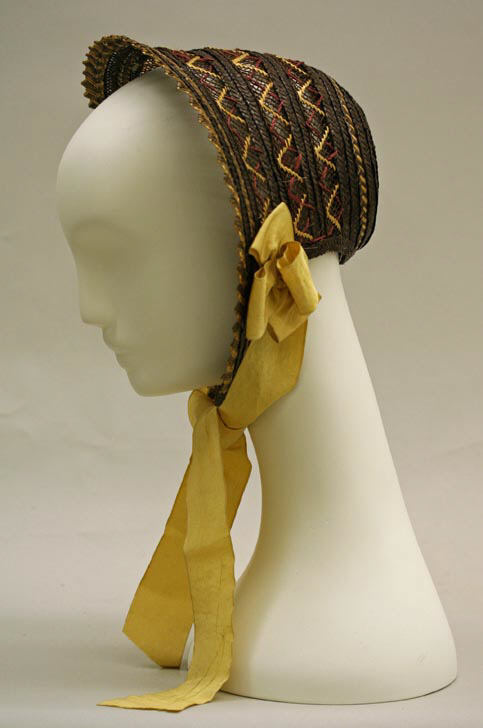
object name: sunbonnet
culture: british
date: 1842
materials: silk, fiber